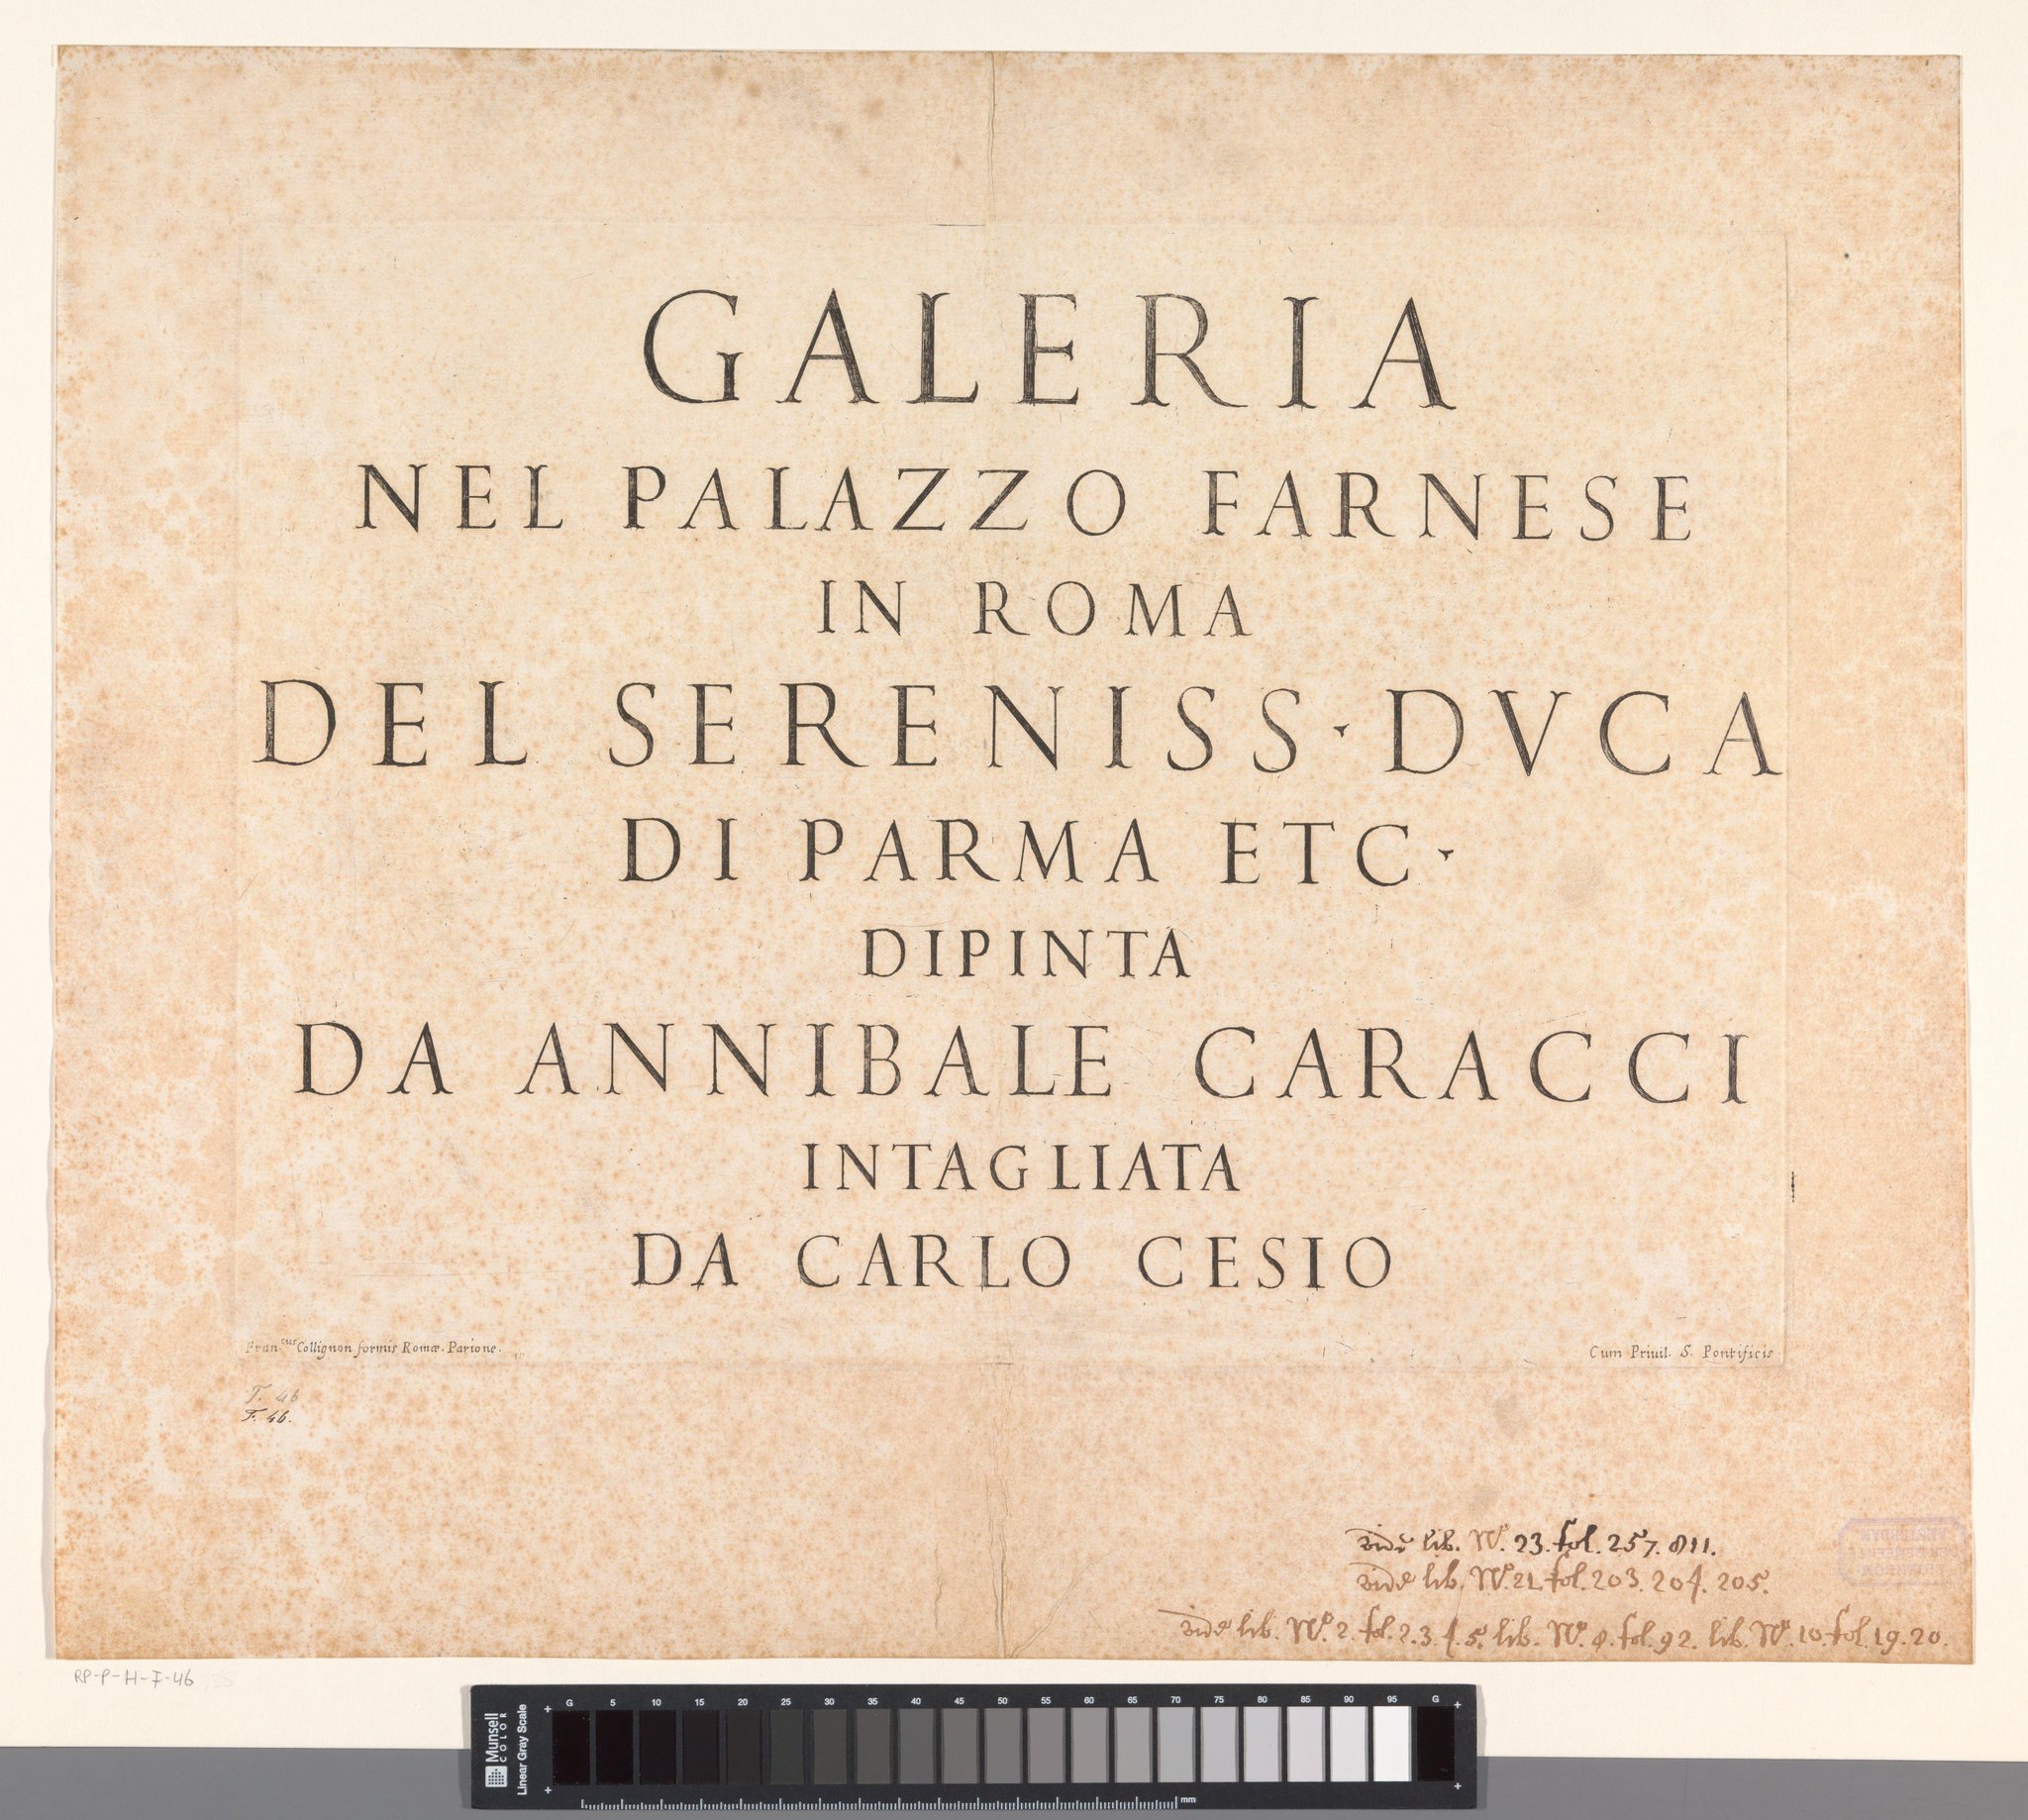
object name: titelprent, frontispice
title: Titelprent met tekst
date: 1657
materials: paper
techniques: etching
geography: rome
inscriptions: inscription: ‘16 guldens’, collector's mark: ‘Hinloopen’, collector's mark: Lugt 11, inscription: ‘[vide?] lib. No. 23. fol. 257.811/ [vide?] lib. No. 21. fol. 203.204.205./ [vide?] lib. No. 2. fol.2.3.4.5. lib. No. 8. fol. 92. lib. No. 10. fol. 19.20.’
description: Titelprent (eerste editie) bij een reeks van 43 prenten naar schilderingen in Palazzo Farnese te Rome. Deze prent maakte oorspronkelijk deel uit van liber nr. 22 van de Atlas van Rome, uit de collectie Hinloopen. In dit album waren een aantal prentreeksen naar bekende zeventiende eeuwse frescoseries bijeengebonden. In 1709 heeft Schijnvoet op last van de burgemeesters van Amsterdam de collectie herordend. De prenten uit liber 22 kwamen terrecht in Schijnvoet boek nr. 10. De laatst gedateerde reeks in het album is gedateerd 1691. Het album moet dus na deze datum gebonden zijn. De band is in de Rijksakademietijd uit elkaar gehaald. De marges van de prenten zijn bij het opbergen in het Rijksprentenkabinet vaak drastisch afgesneden. Van een aantal series waren de prenten teruggeslagen om in het album te passen. (Zie: Waals, Jan van der. De prentschat van Michiel Hinloopen. 's-Gravenhage: SDU uitgeverij, 1988, pp. 173-174.)